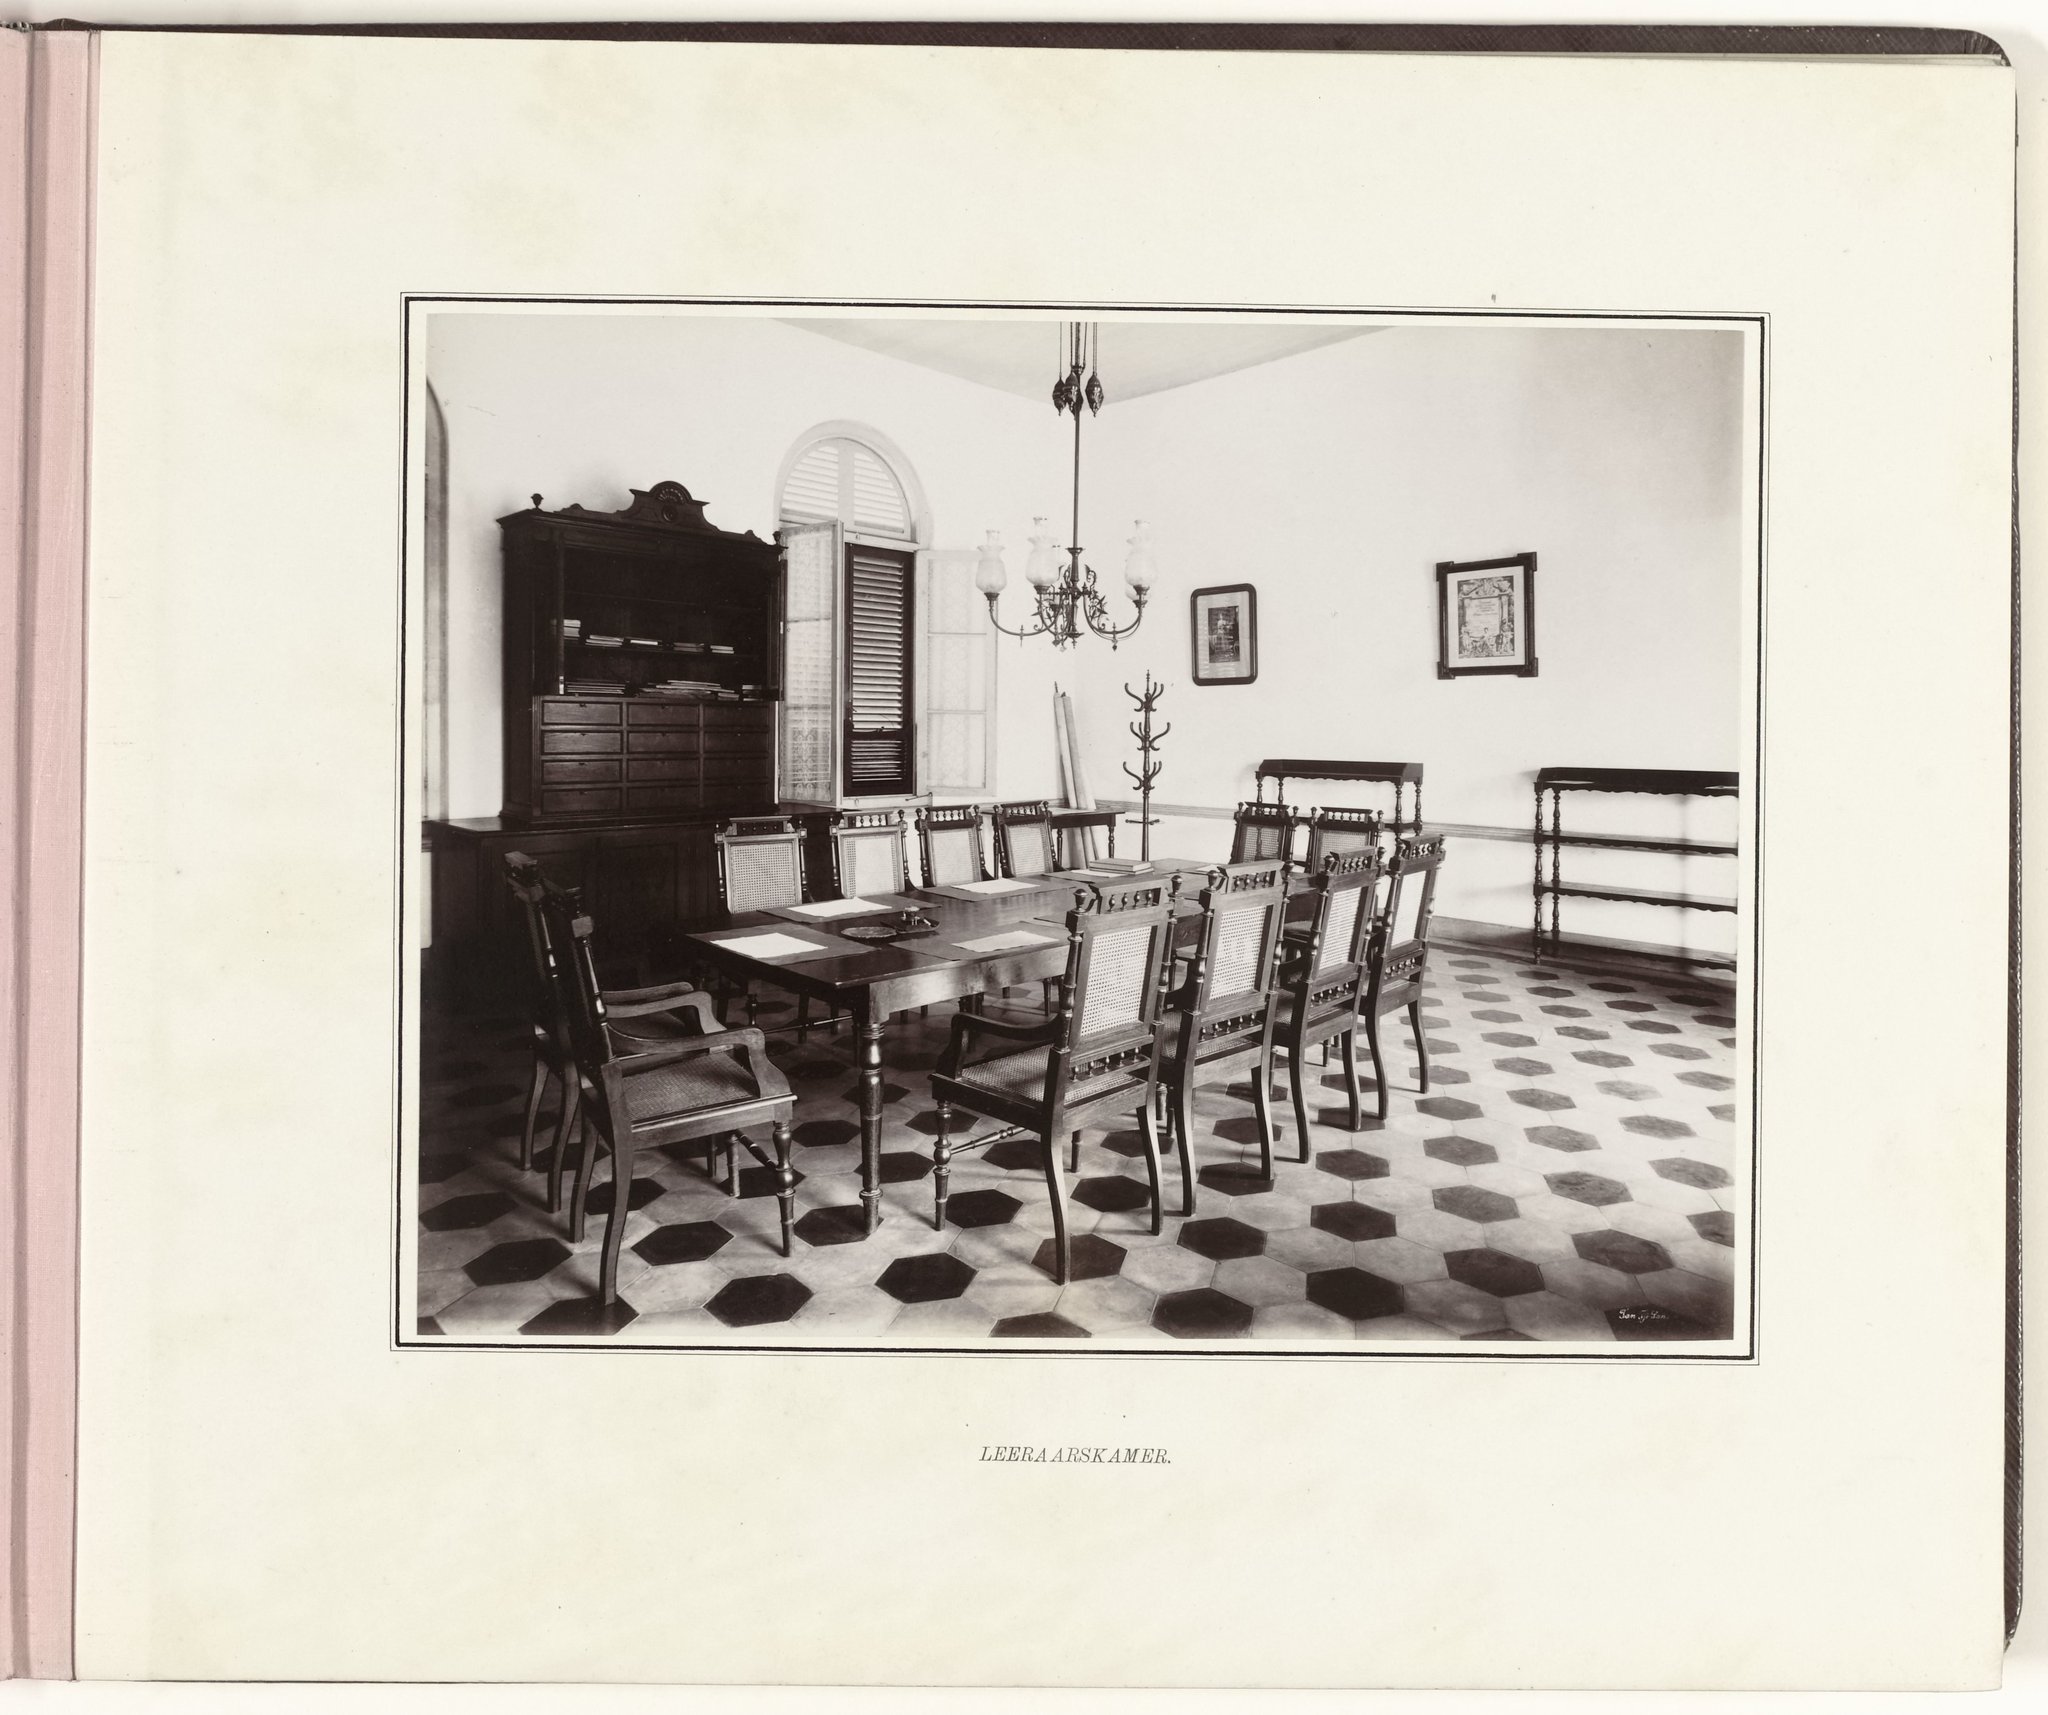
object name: photograph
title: Leeraarskamer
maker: tan tjie lan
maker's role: fotograaf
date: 1902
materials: photographic support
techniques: albumen print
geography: weltevreden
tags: colonial system, vocational education, e.g.: junior technical school, vocational education, e.g.: junior technical school (+ building ~ education, tuition)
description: De lerarenkamer van de School tot Opleiding van Inlandse Artsen (STOVIA) te Weltevreden. Kamer met vergadertafel en stoelen. Ingeplakte foto in het album van ca. 1902 getiteld: School tot Opleiding van Inlandsche Geneeskundigen / Ter Herinnering aan de Inhuldiging van Koningin Wilhelmina en tot Heil der Bevolking van Nederlandsch Oost-Indie.